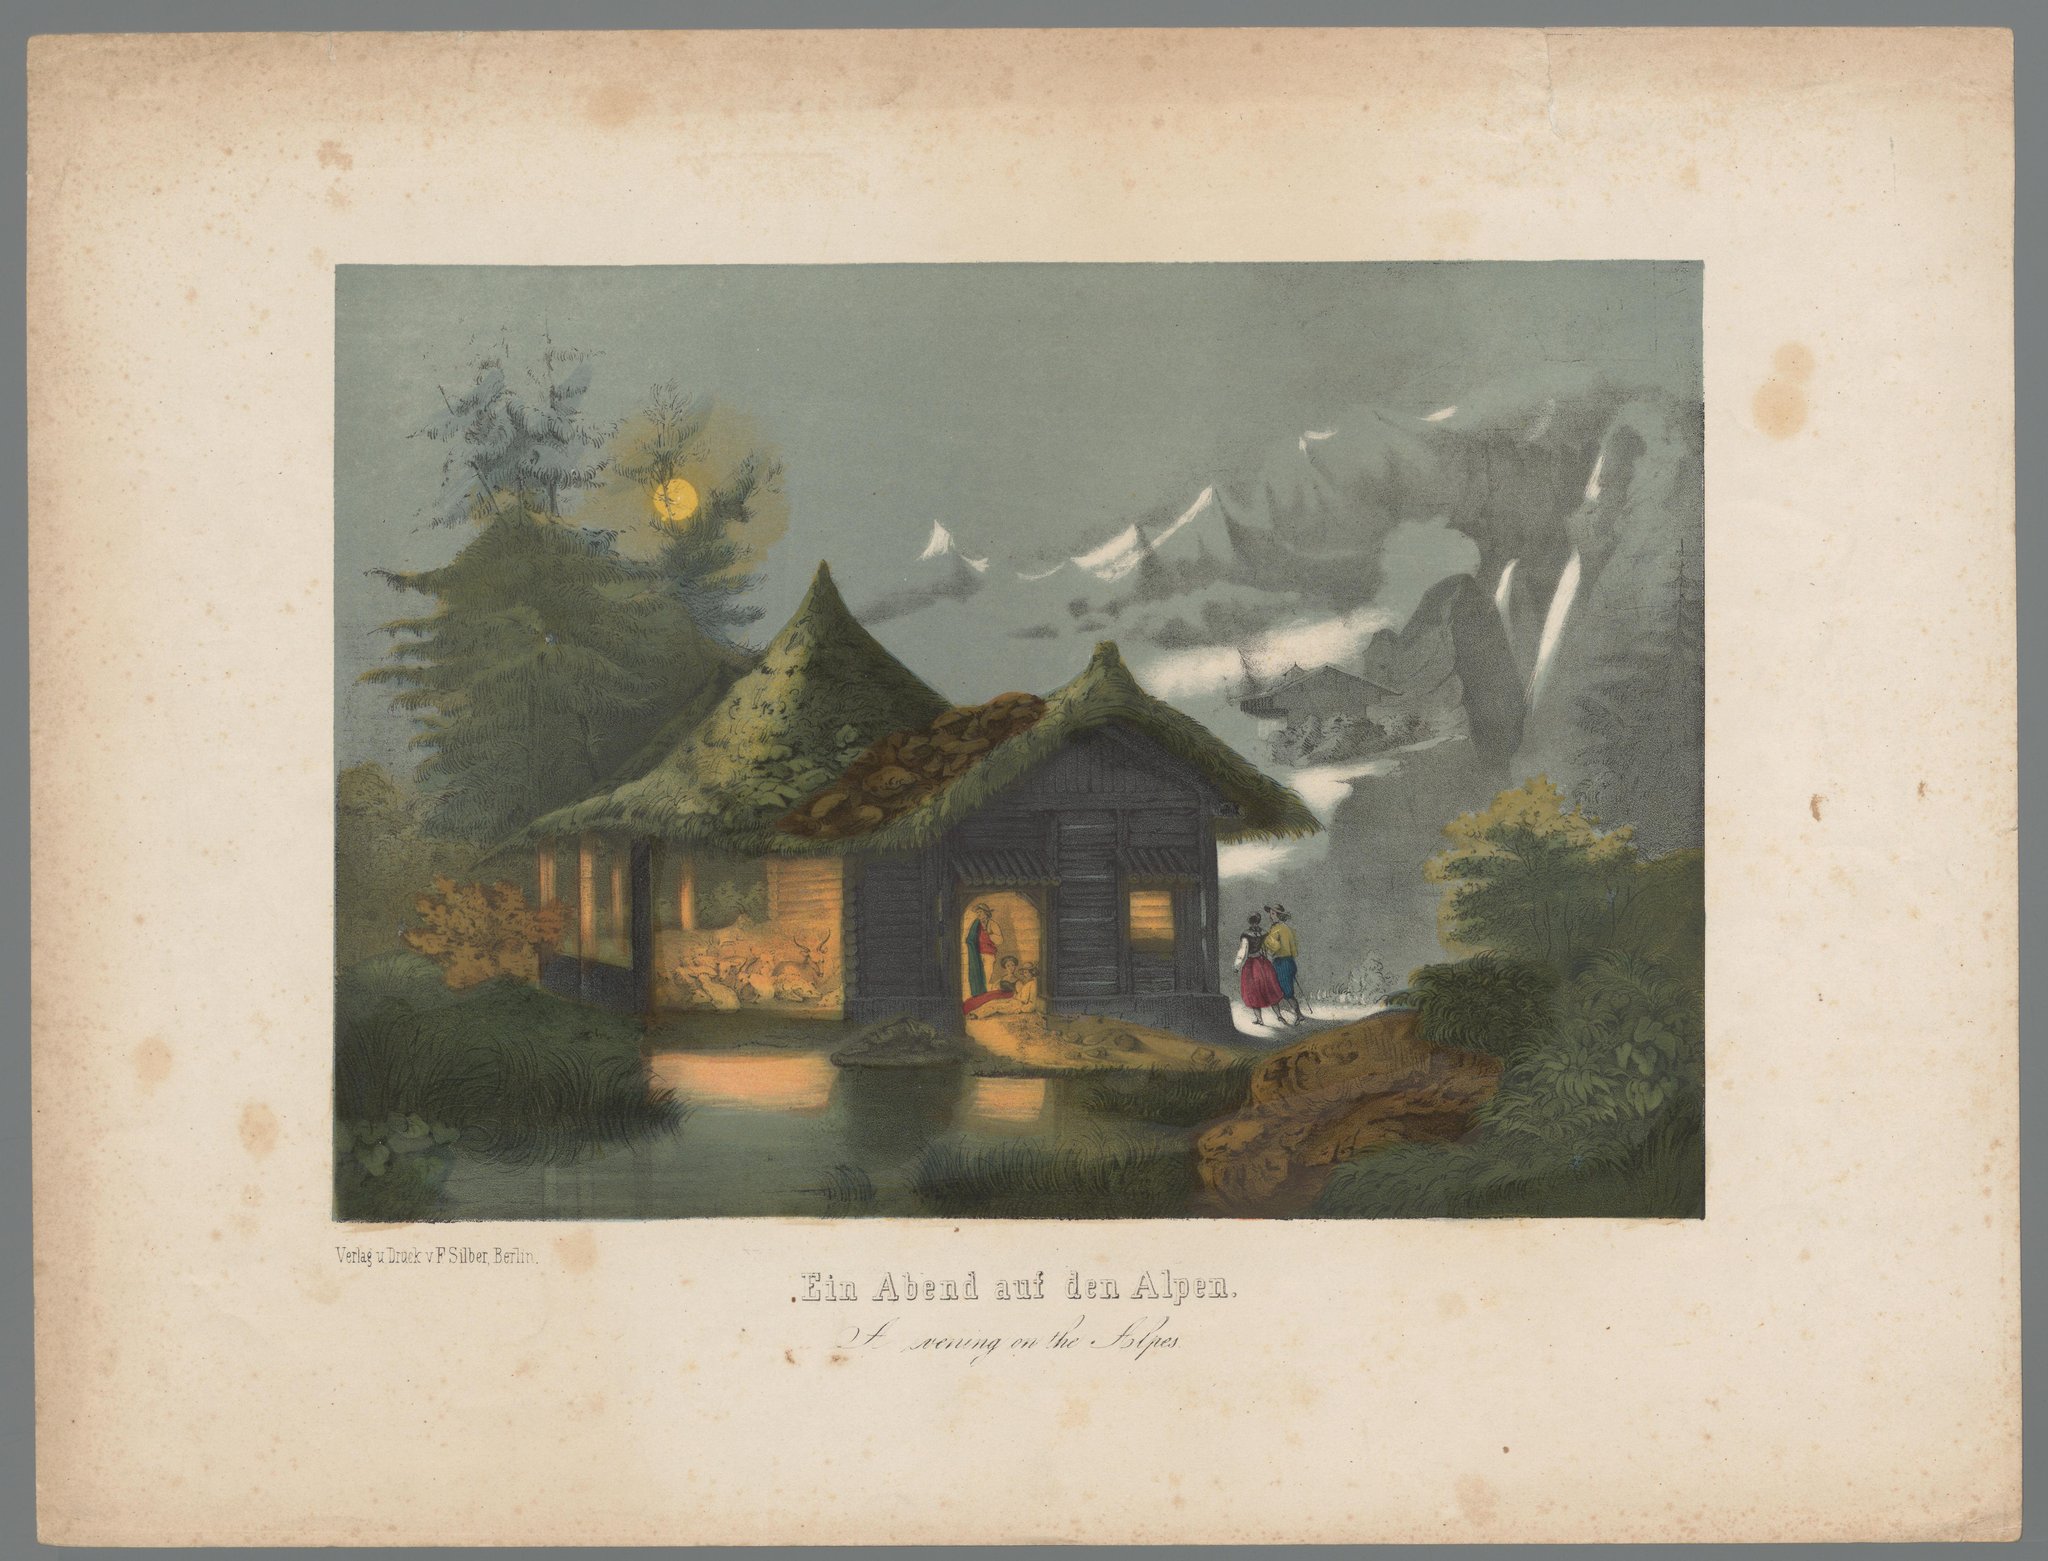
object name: print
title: Ein Abend auf den Alpen / A evening on the Alpes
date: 1830-1875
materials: paper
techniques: lithograph, hand coloring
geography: berlin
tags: barn, full moon, landscapes in the temperate zone (+ landscape with figures, staffage), mountains